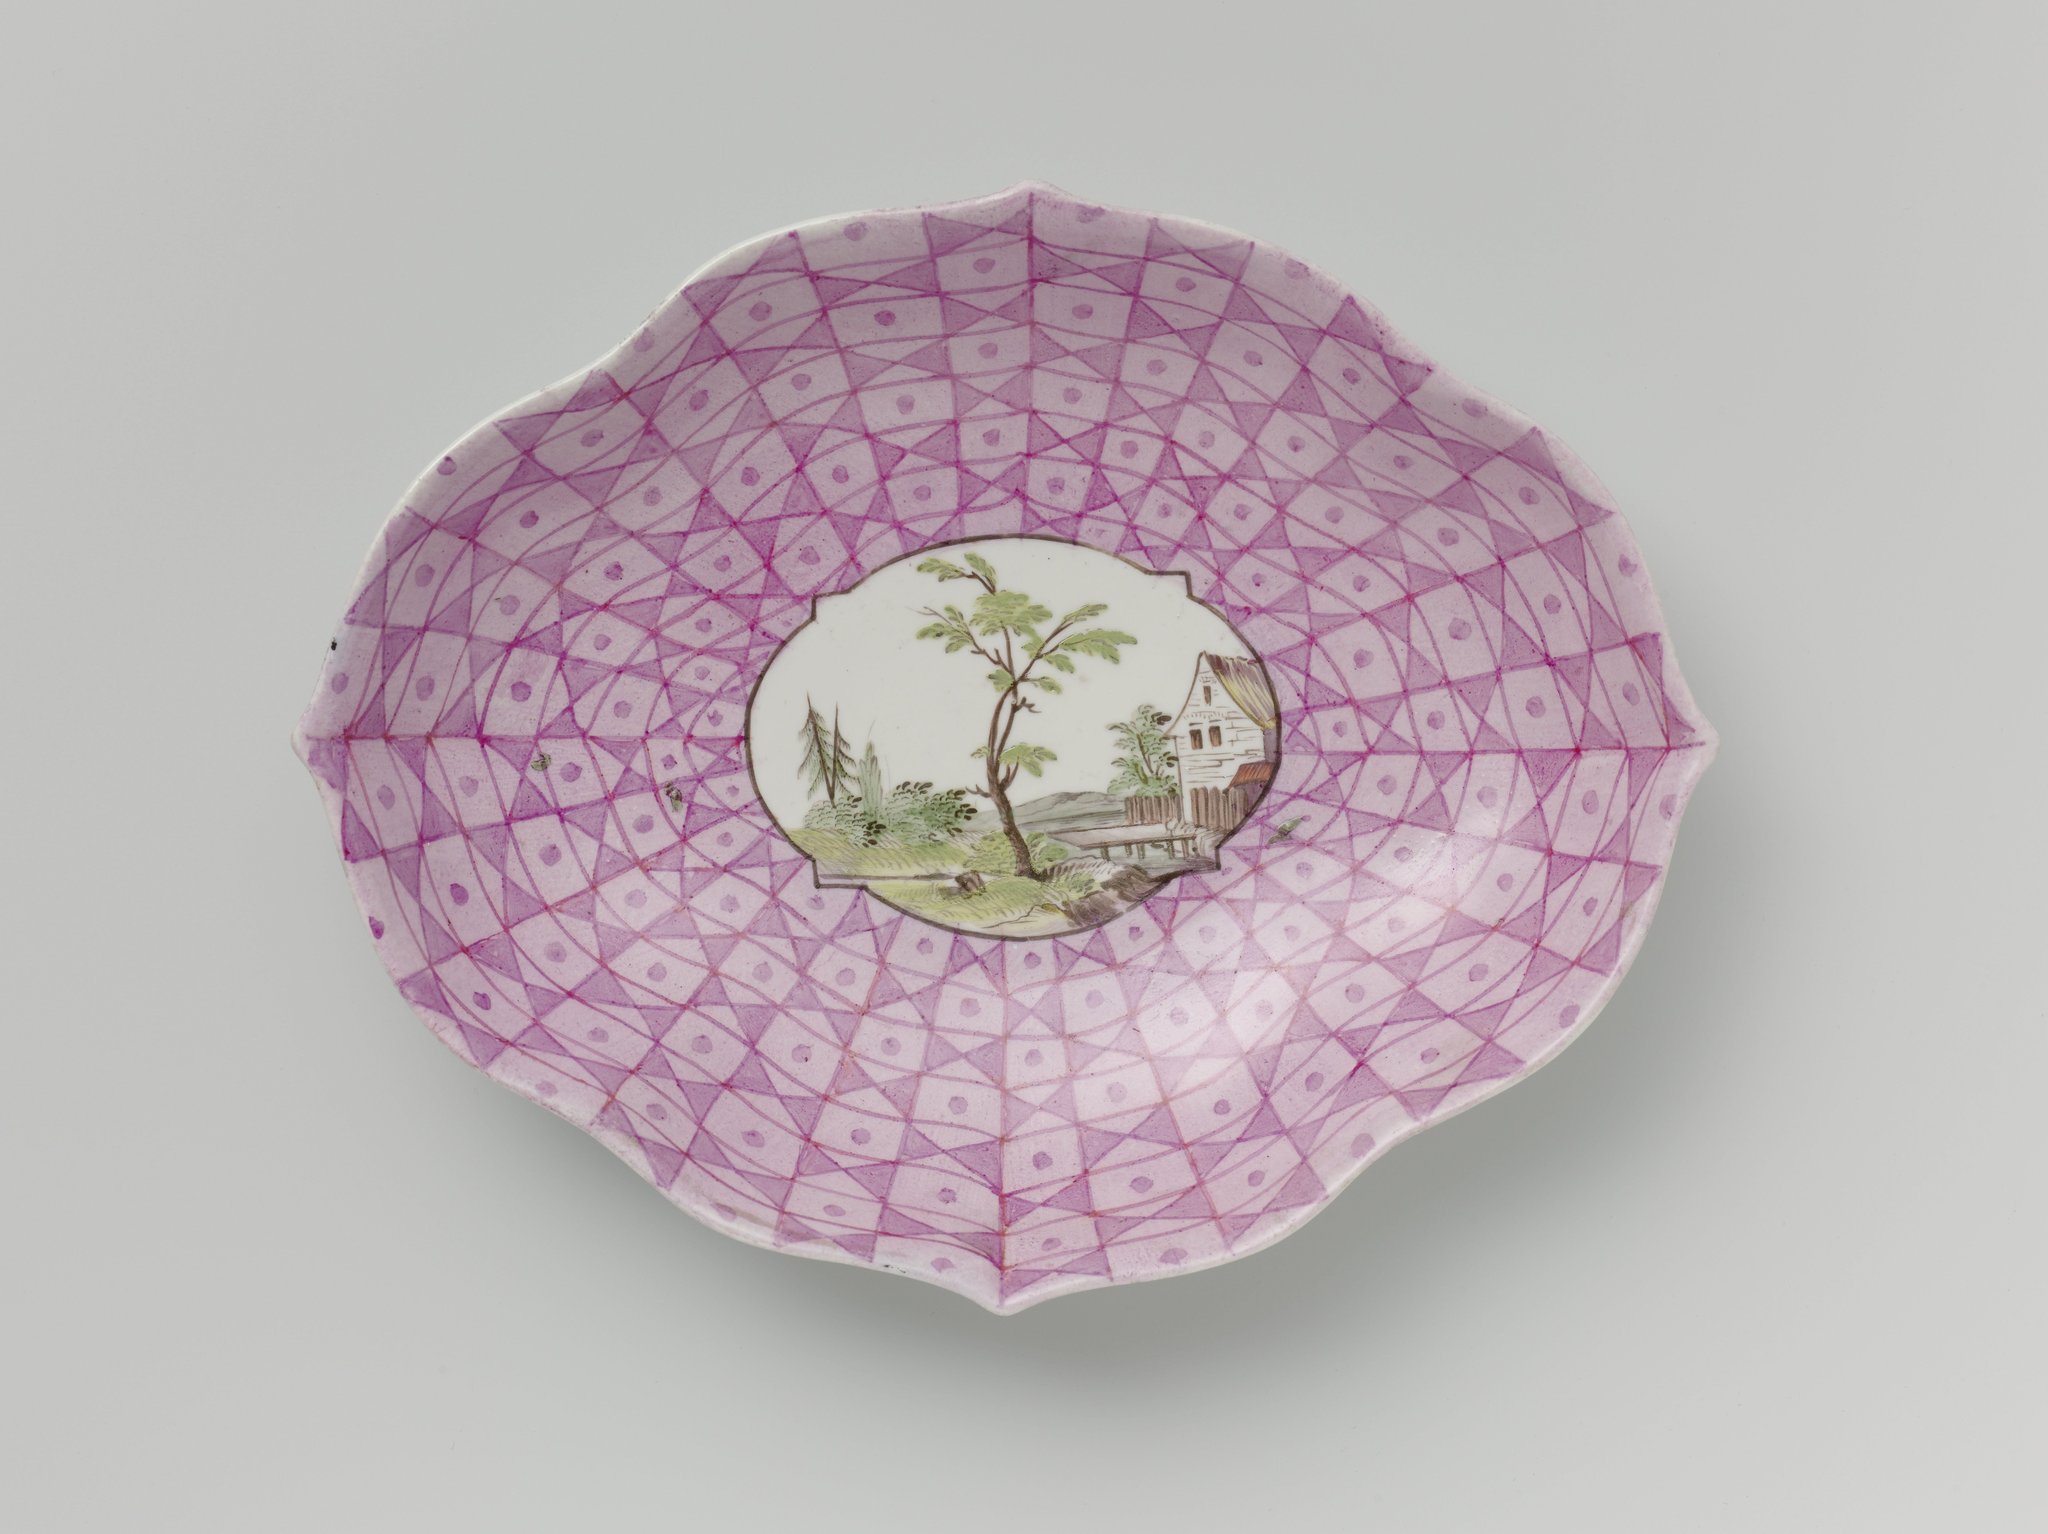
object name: pattipan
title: Pattipan met een veelkleurig landschap in een medaillon uitgespaard in een geometrisch patroon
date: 1759-1771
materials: porcelain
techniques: painted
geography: weesp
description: Pattipan met een veelkleurig landschap in een medaillon gespaard in een paars geometrisch patroon. Gemerkt met twee gekruiste zwaarden en drie bollen in onderglazuurblauw, ingegrift 2.